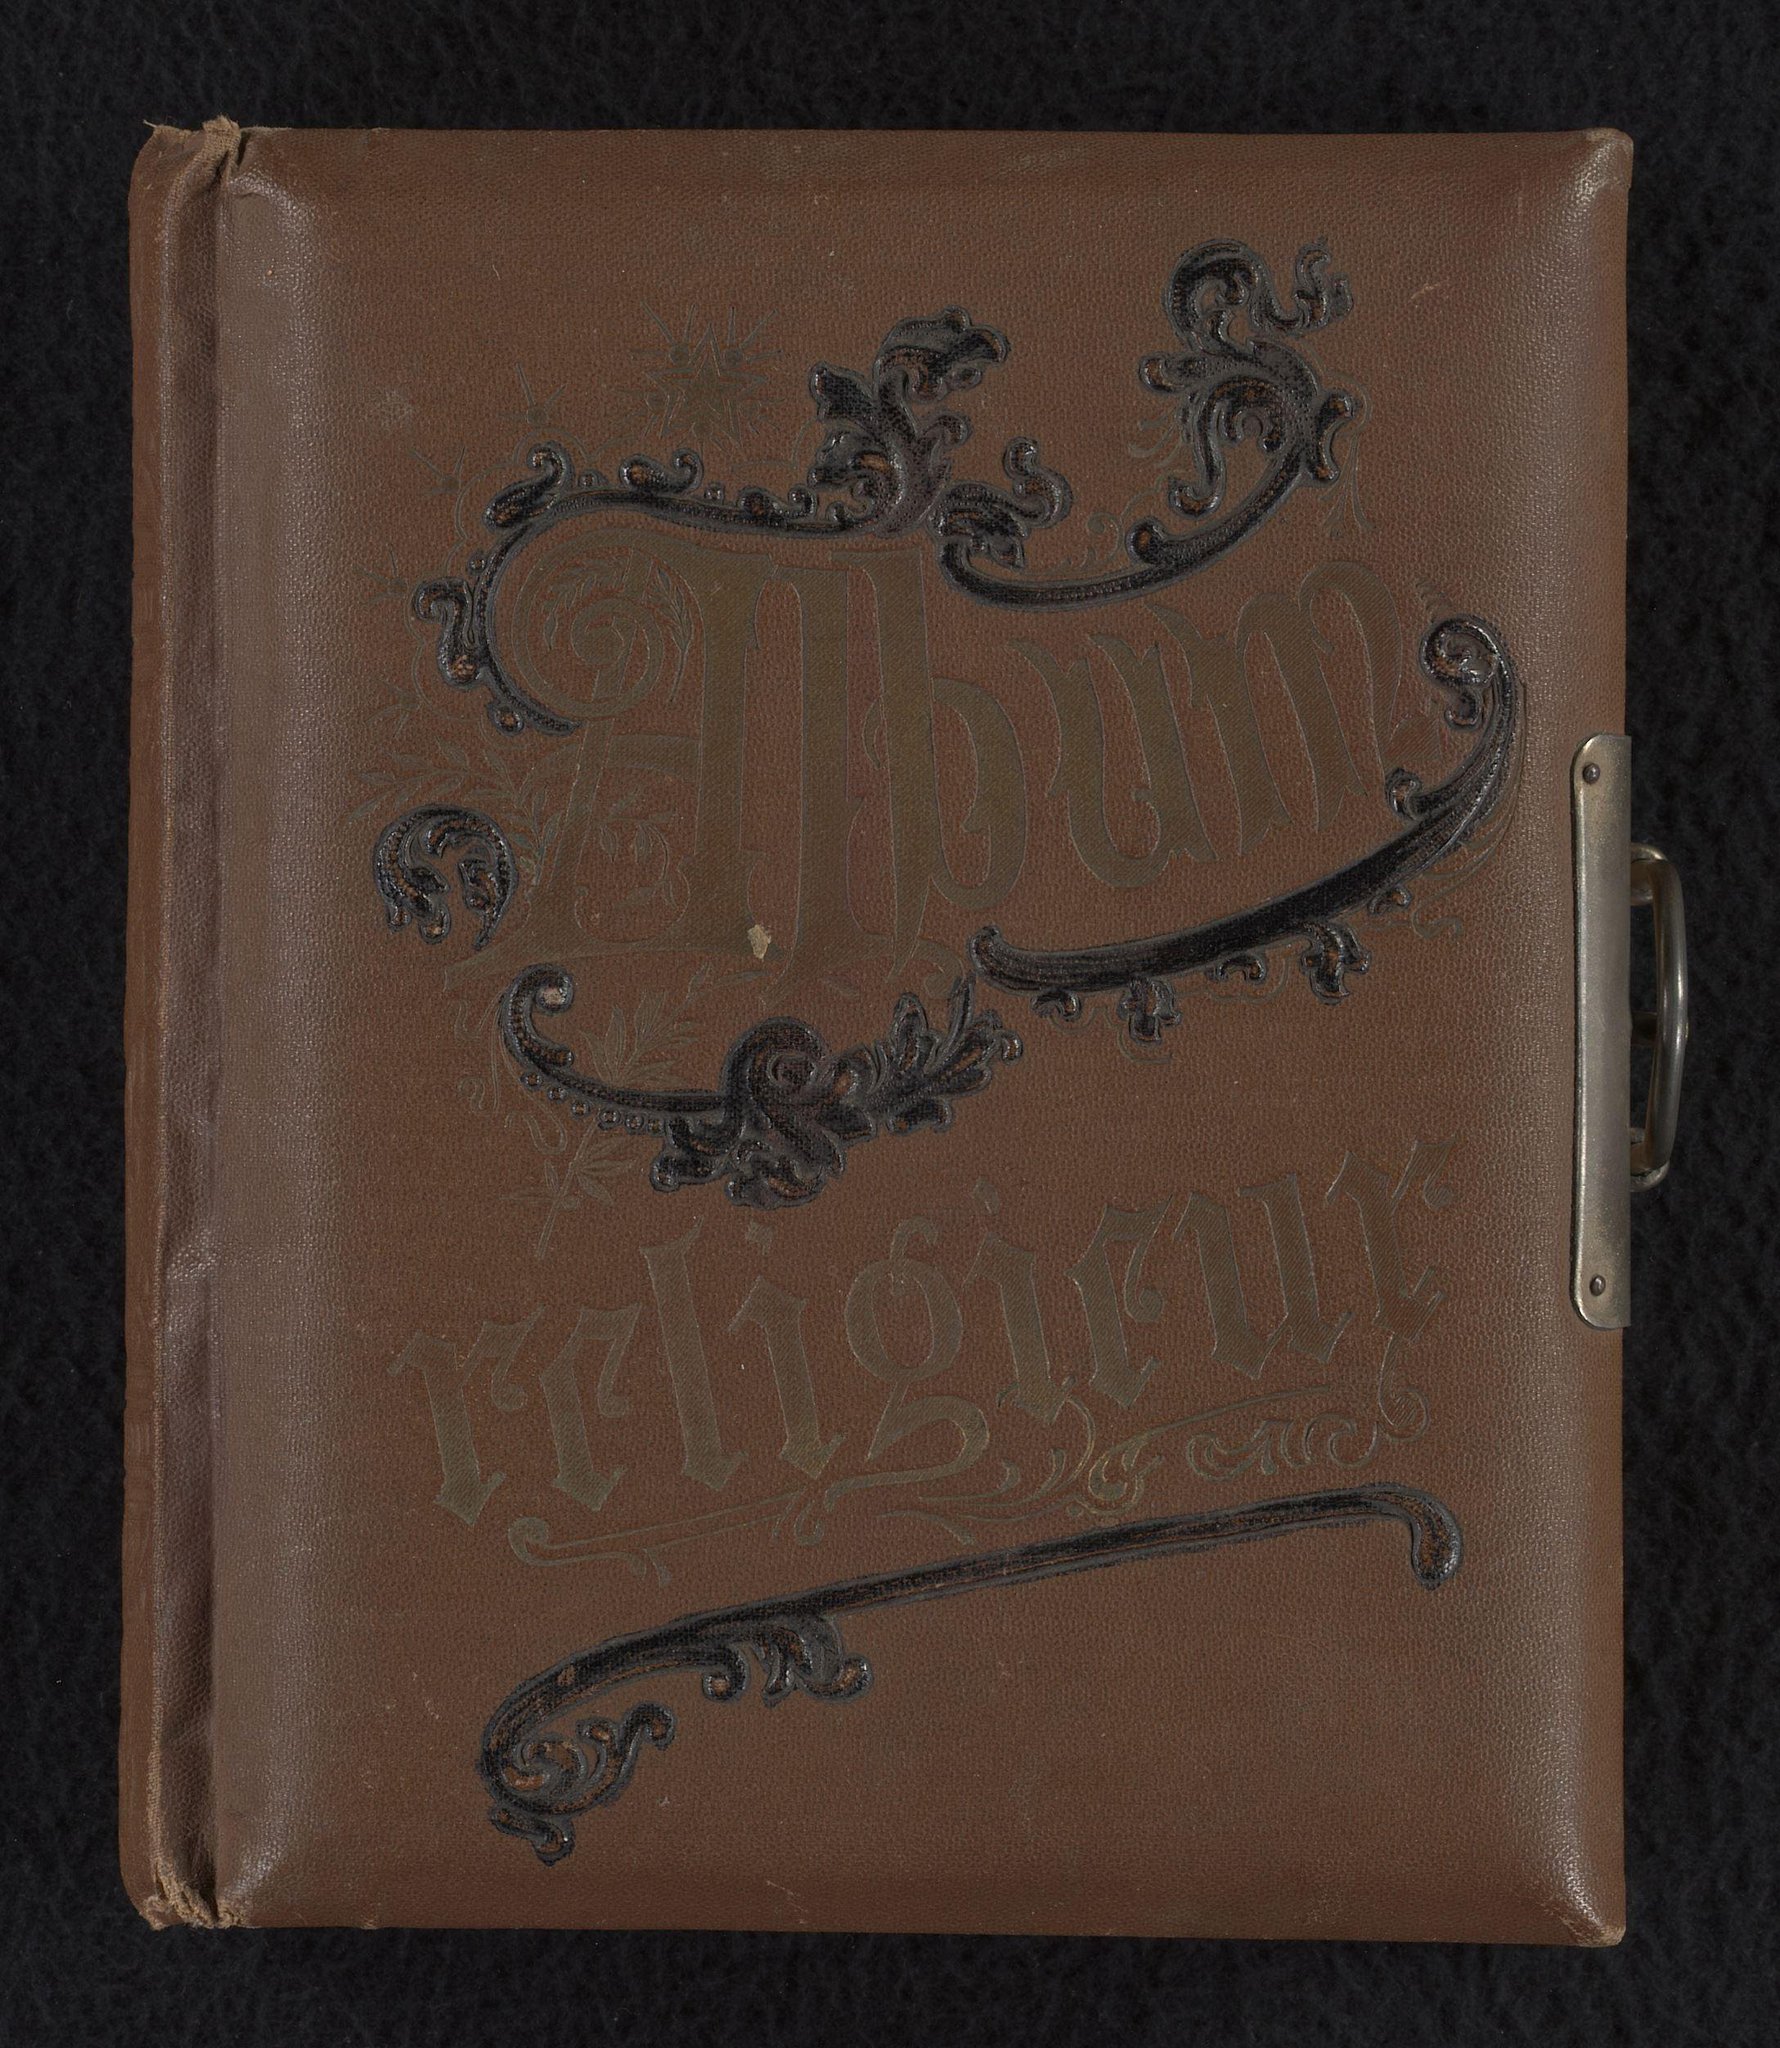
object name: photograph album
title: Album Religieux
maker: Anonymous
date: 1860-1900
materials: cardboard, leather, metal, paper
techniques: color on snow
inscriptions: collector's mark: ‘DIENST/ VERSPREIDE/ RIJKSKOLLEKTIES/ (...) A 771’, number: ‘002’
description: Fotoalbum 36 pagina's met ieder een met gepreegde rand omkaderde passe-partout voor foto's van ongeveer 8 bij 13 centimeter. Op het voorplat staat de titel Album Religieux.